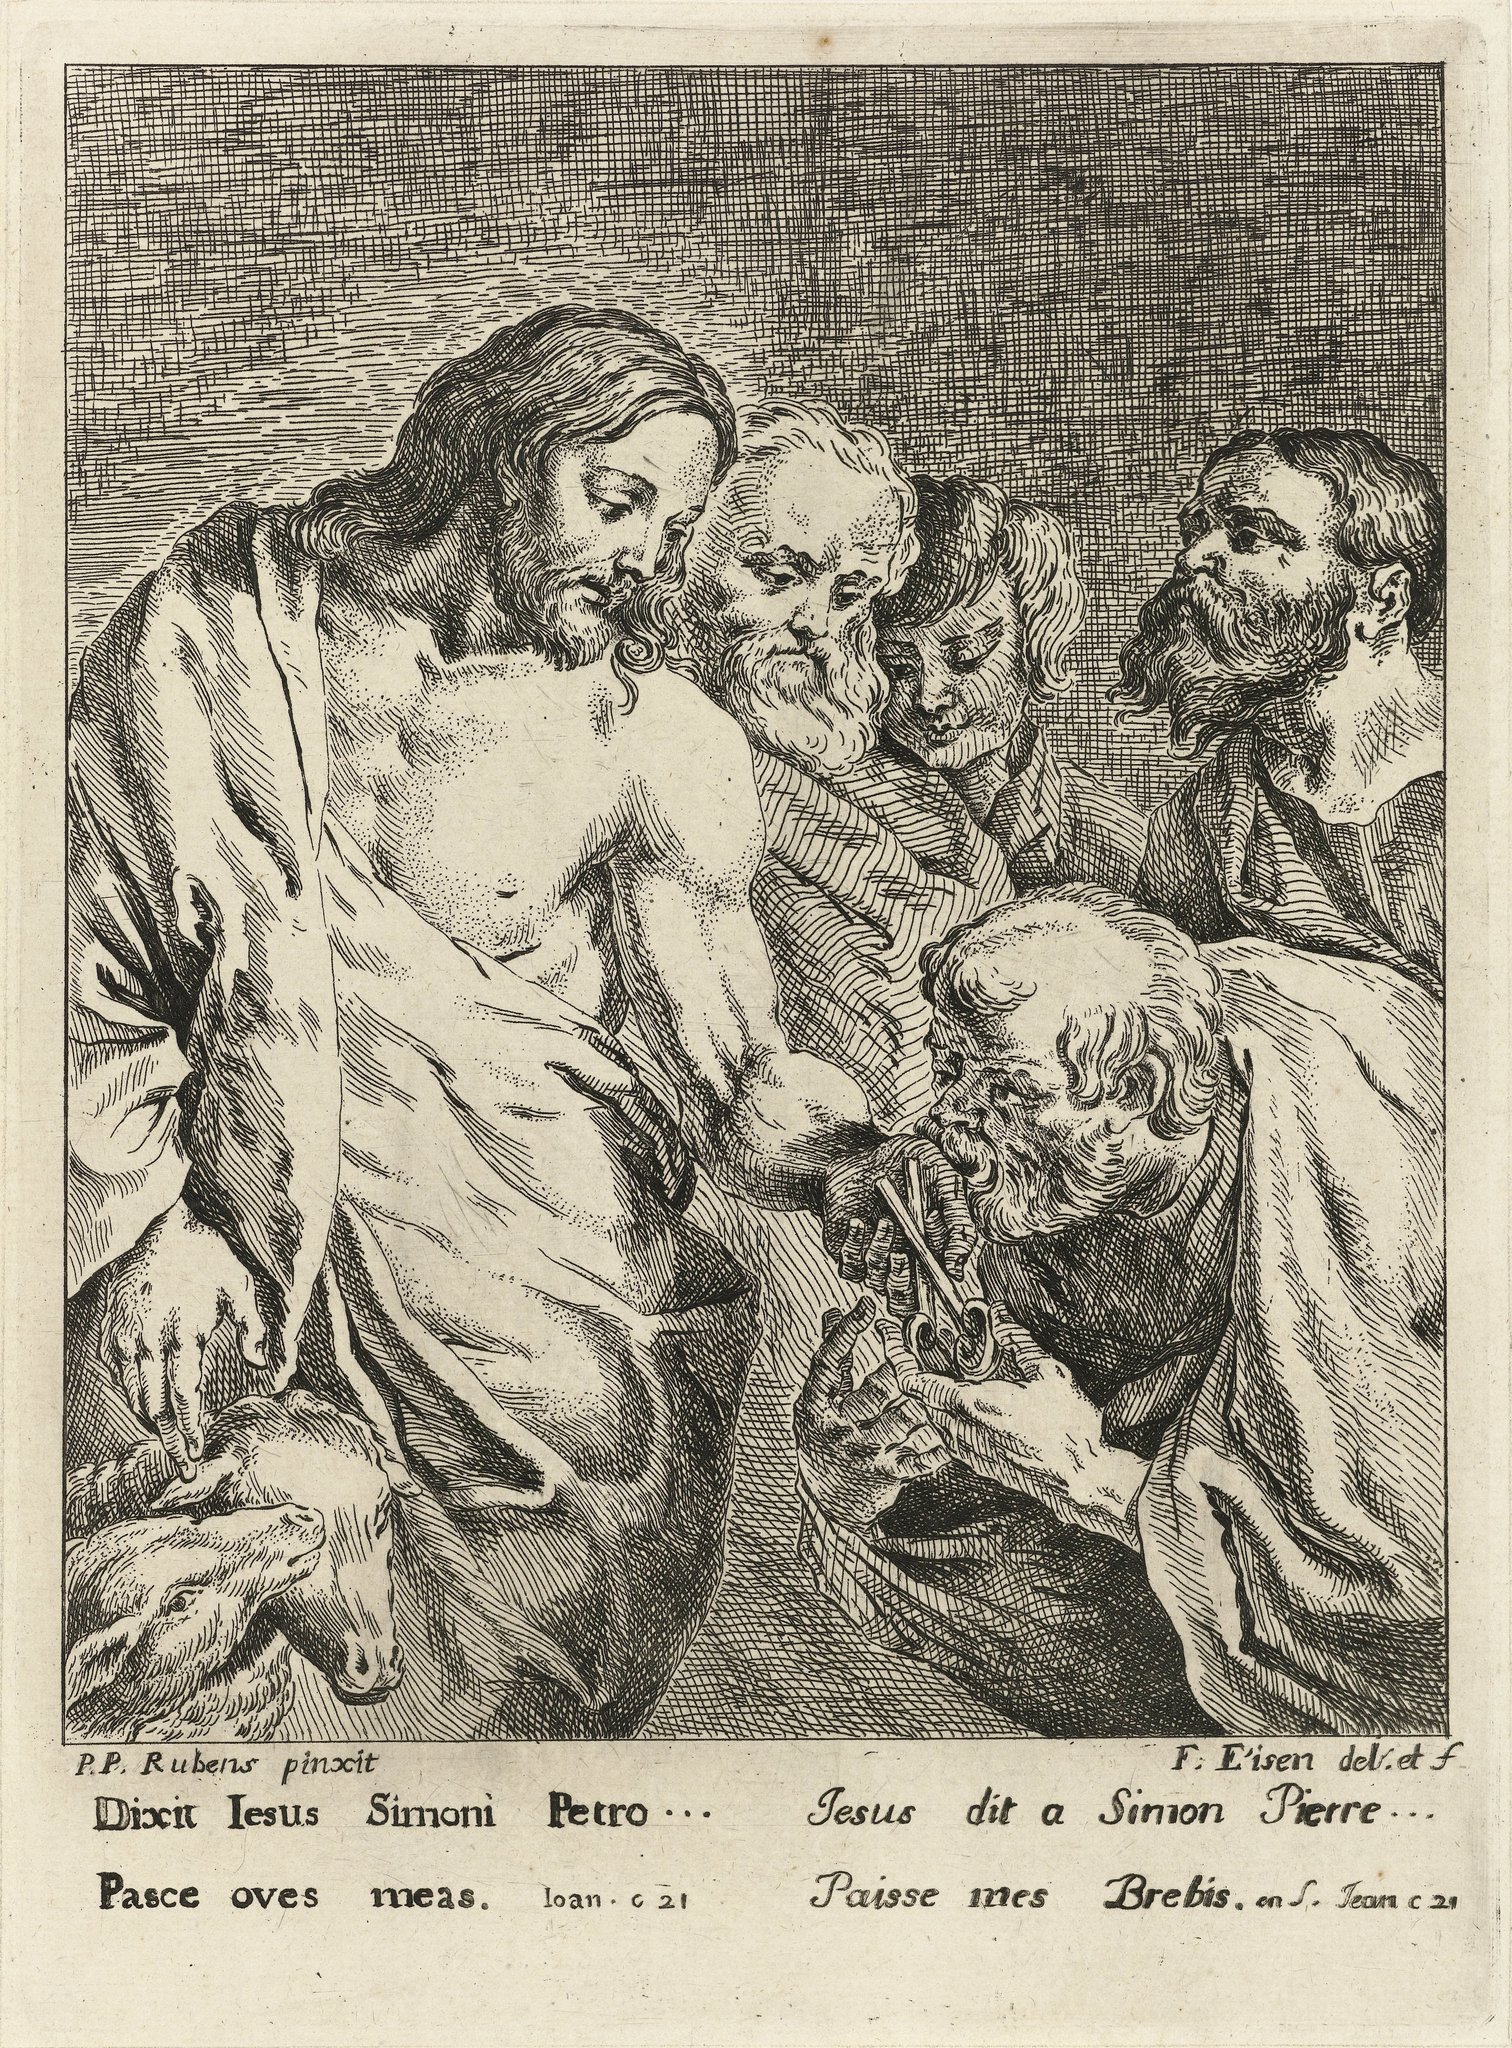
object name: print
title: Christus geeft de sleutels aan Petrus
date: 1705-1778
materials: paper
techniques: etching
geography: antwerp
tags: christ gives the keys of heaven to peter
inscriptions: collector's mark: Lugt 240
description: Christus geeft de sleutels aan Petrus. Op de achtergrond drie andere discipelen. Onder de voorstelling twee regels Latijn.